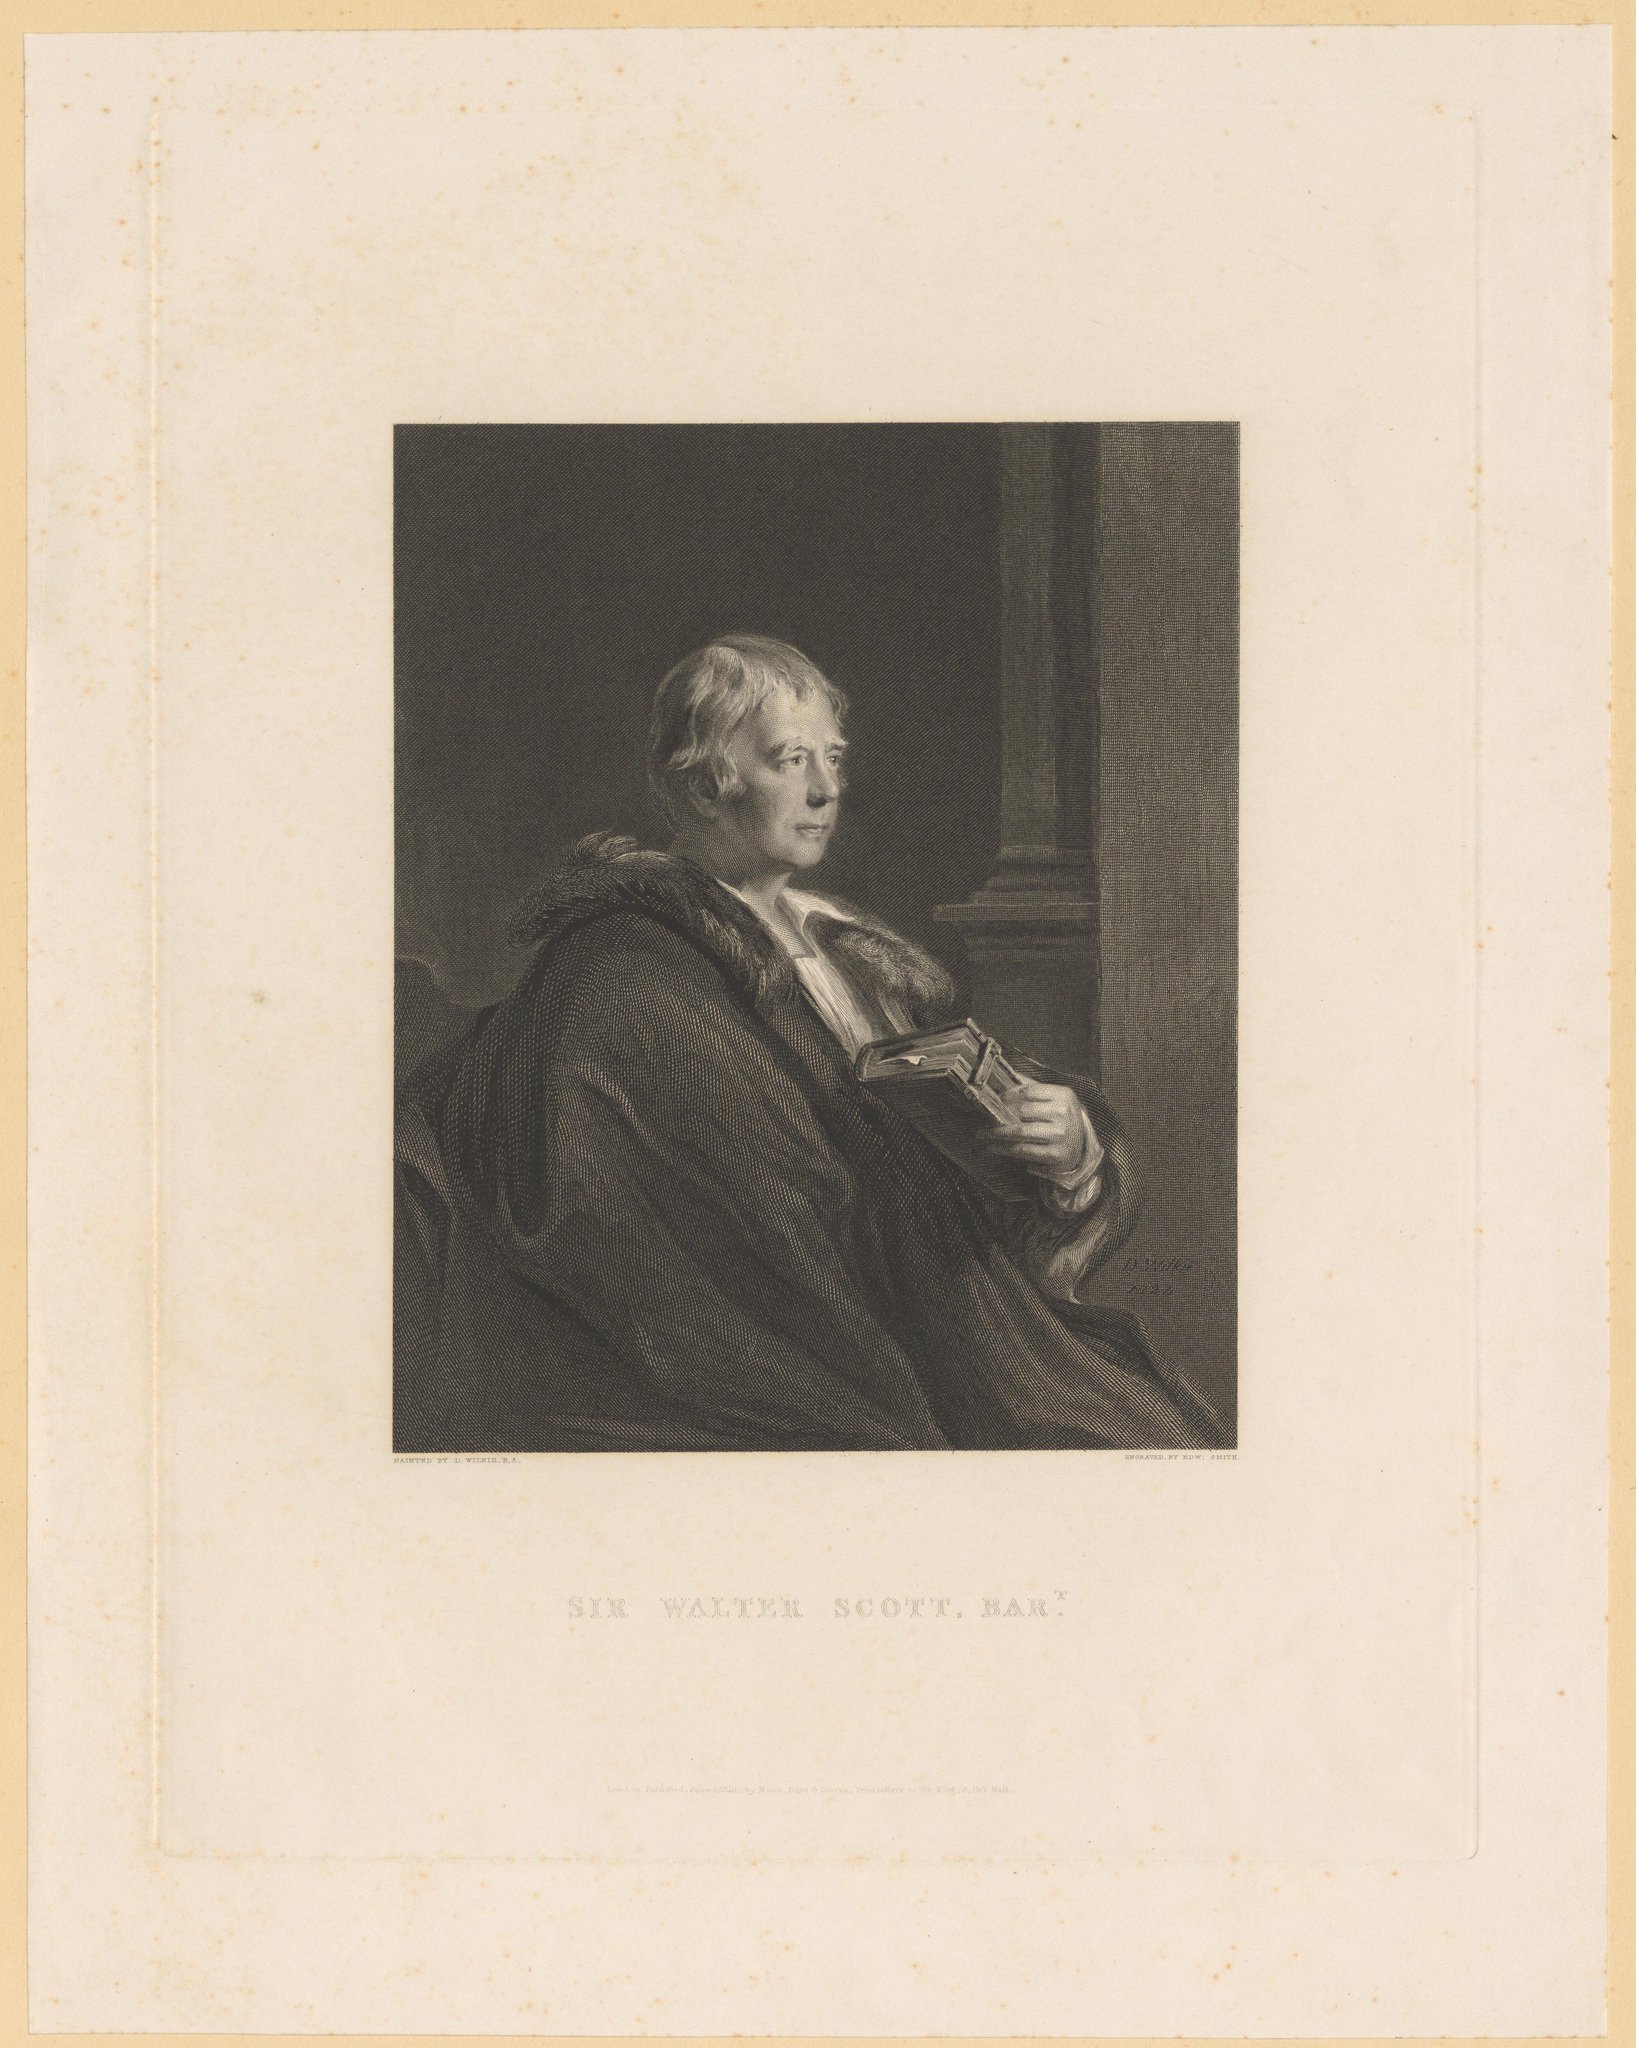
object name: print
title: Portret van Walter Scott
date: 1806-1831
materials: paper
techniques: engraving, etching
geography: london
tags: walter scott, historical persons, portrait of a writer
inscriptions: collector's mark: Lugt 2228